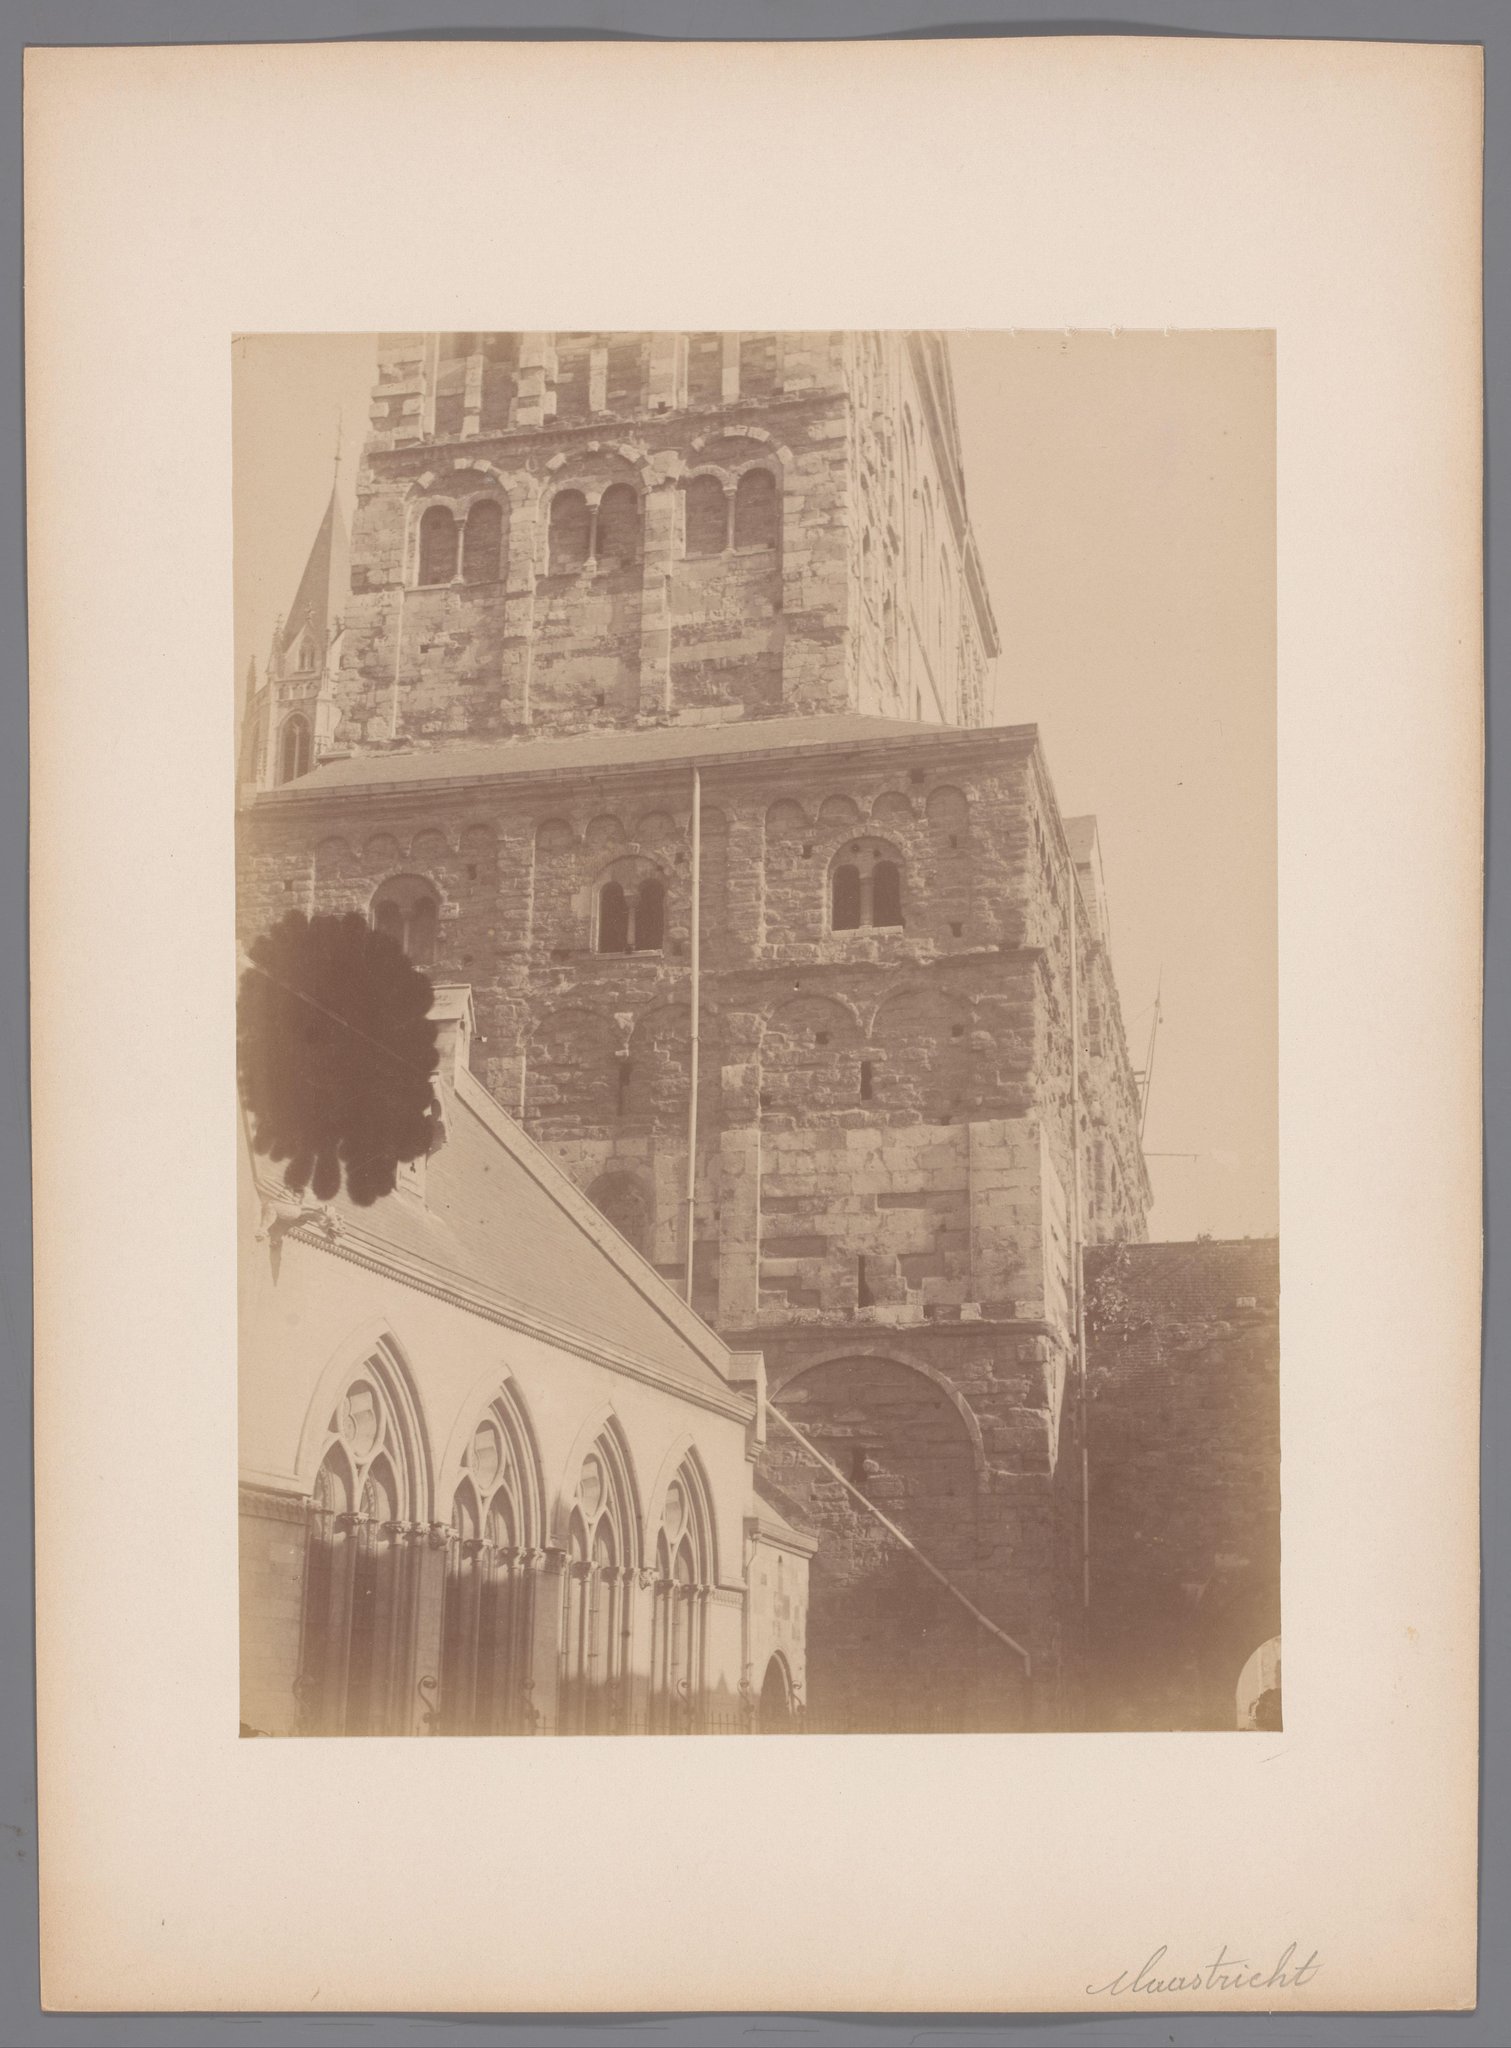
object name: photograph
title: Detail van de Sint-Servaasbasiliek te Maastricht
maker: anoniem (monumentenzorg)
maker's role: fotograaf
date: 1893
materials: cardboard, photographic support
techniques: albumen print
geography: maastricht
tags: parts of church exterior and annexes: tower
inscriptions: annotation: ‘Maastricht St. Servaas/ noordaanzicht v/d Toren’, annotation: ‘Maastricht’